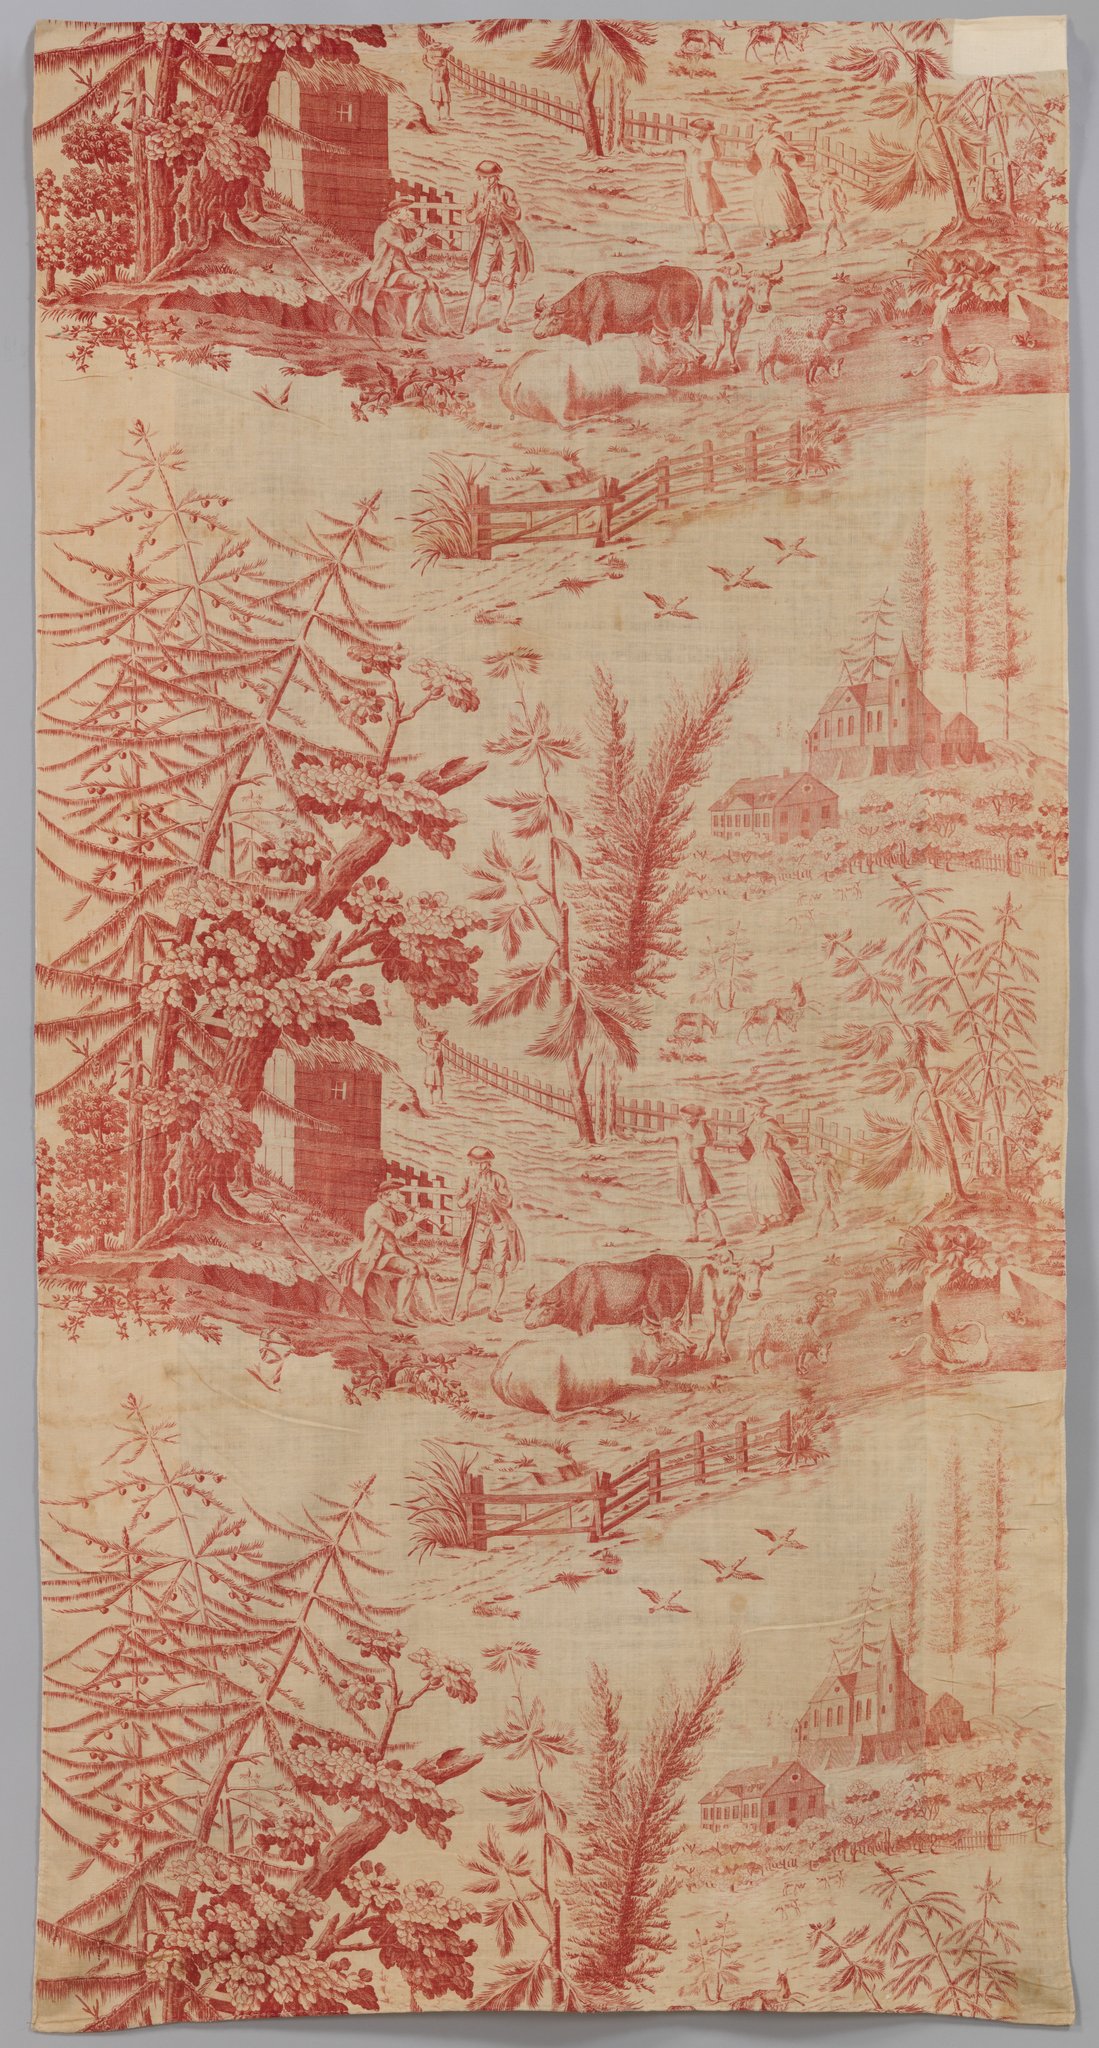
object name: piece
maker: bromley hall printworks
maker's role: manufactory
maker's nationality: english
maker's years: 1694-1823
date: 1770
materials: cotton, linen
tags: animals,men,women,trees